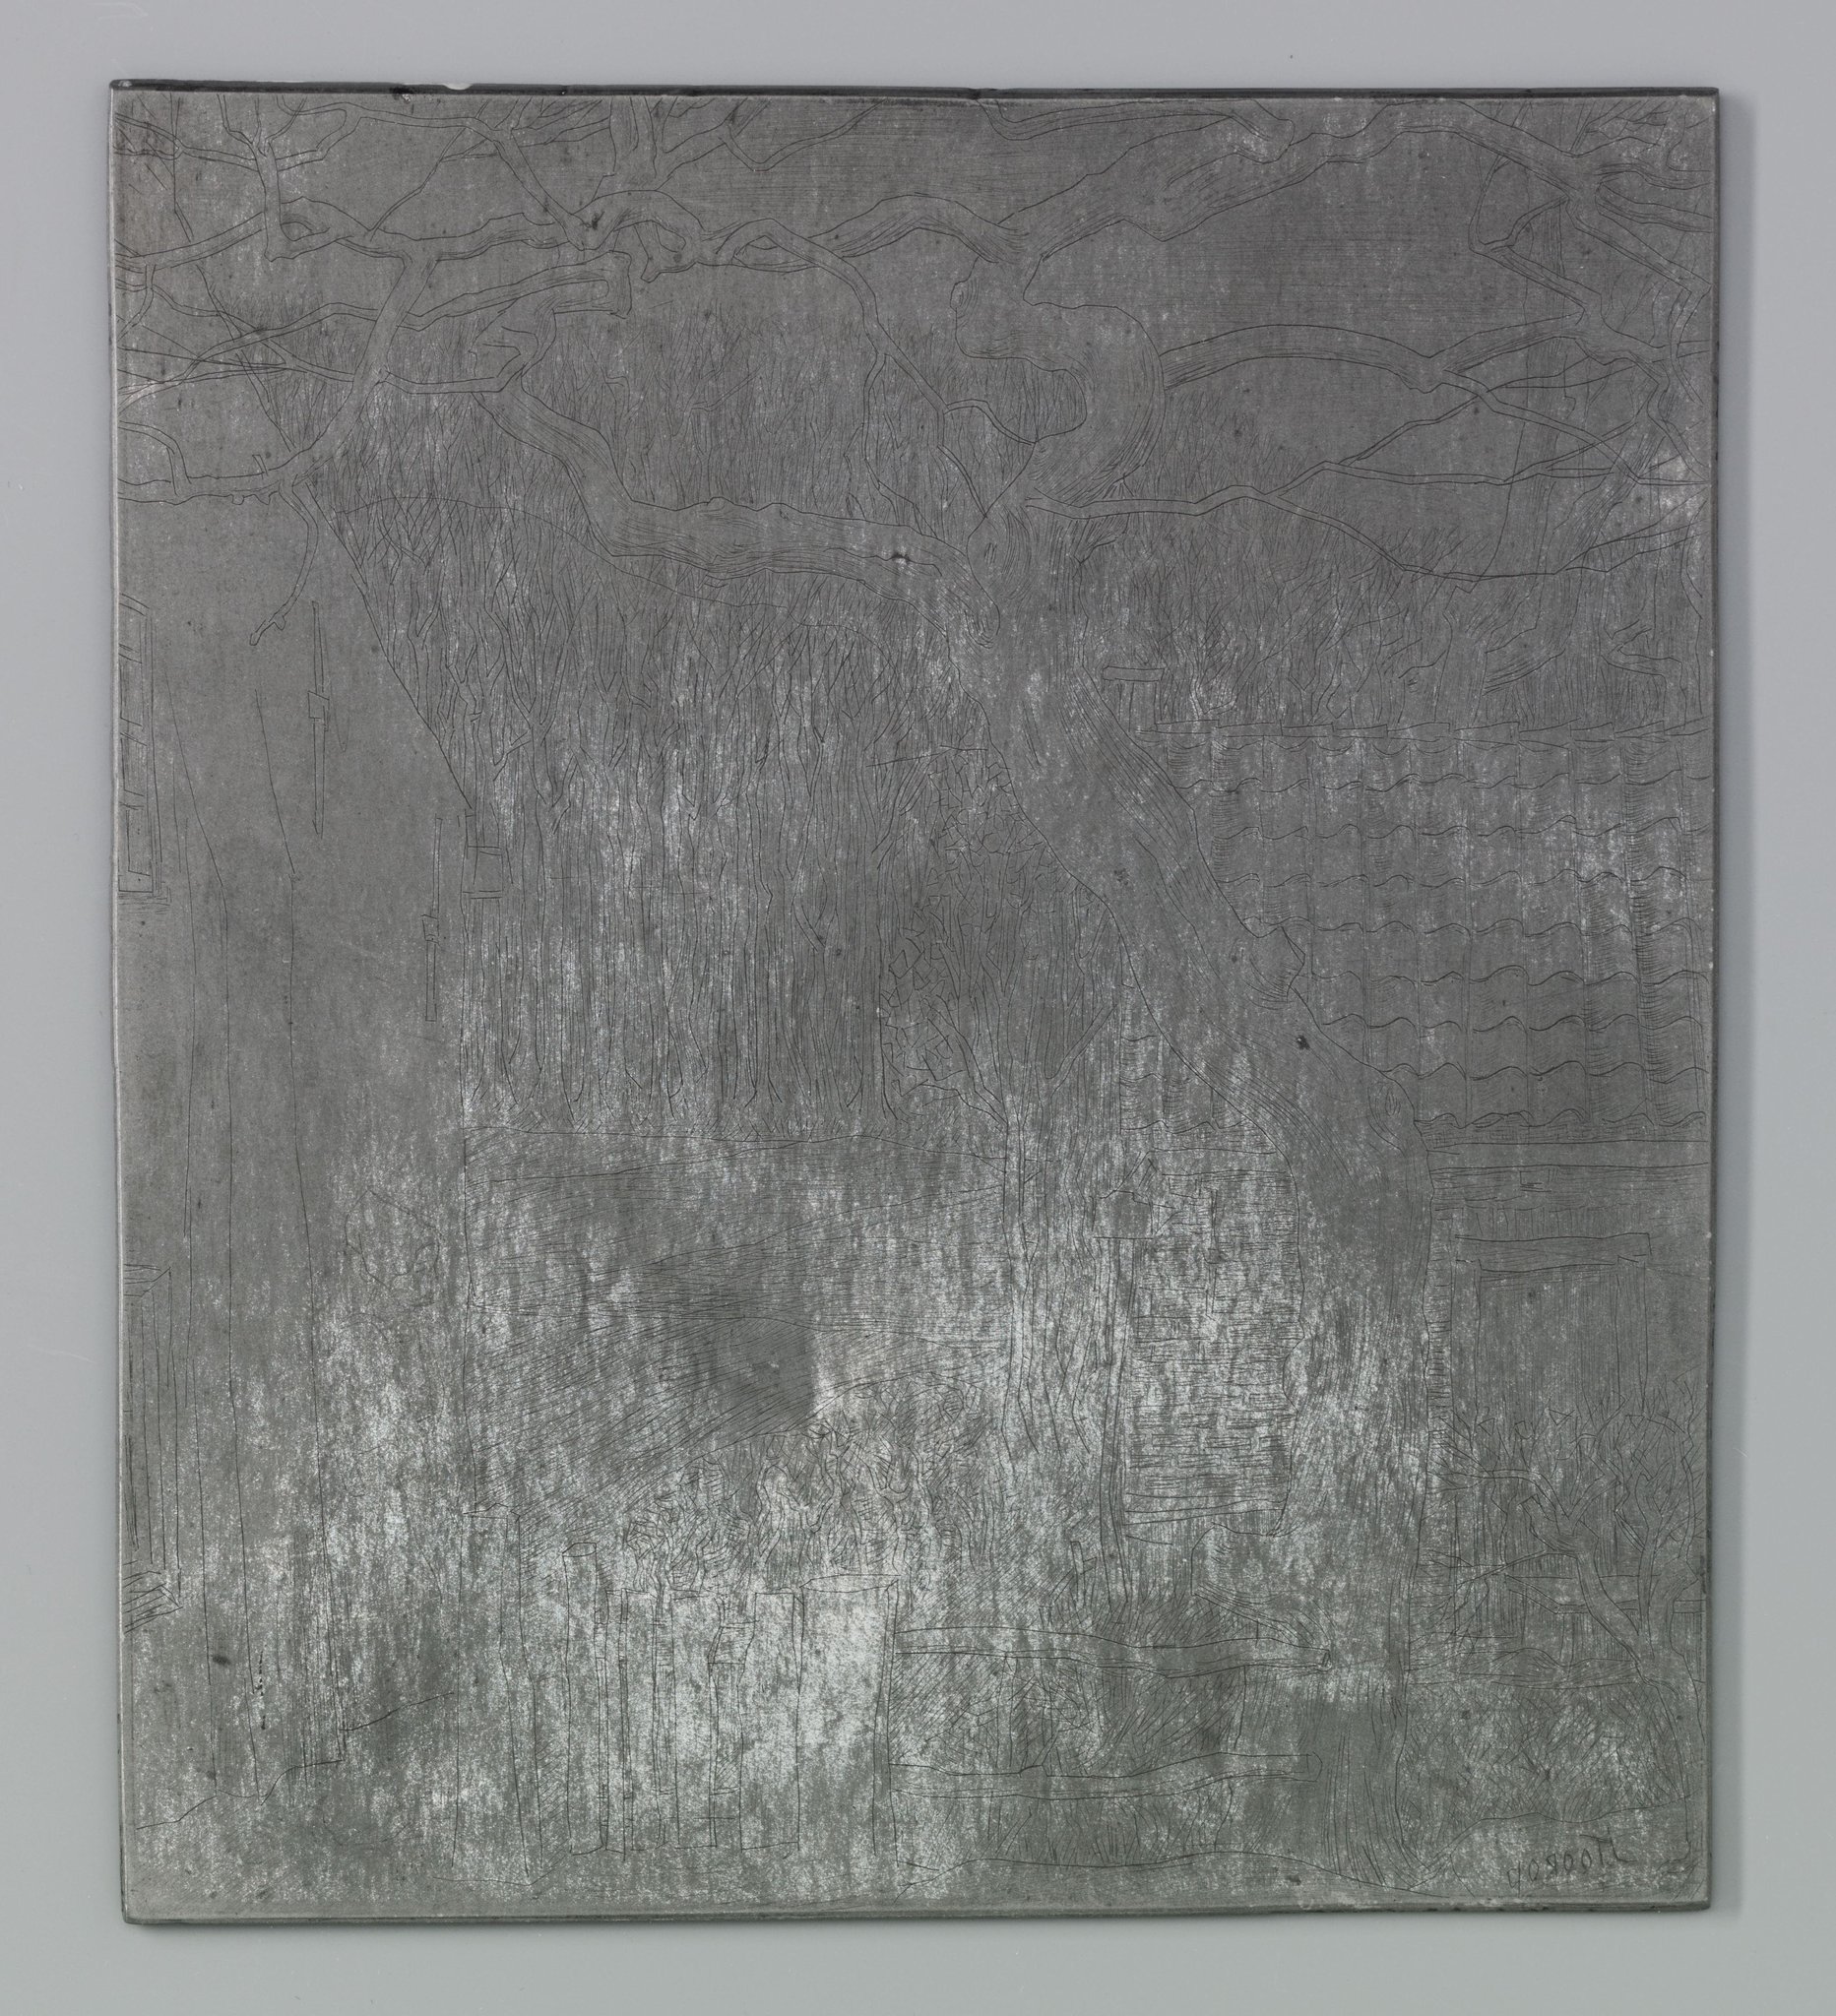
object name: zinkplaat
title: Boom bij twee huizen aan een bosrand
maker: jan toorop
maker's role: draughtsman, painter, print maker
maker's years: 1858-1928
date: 1897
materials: zinc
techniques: drypoint